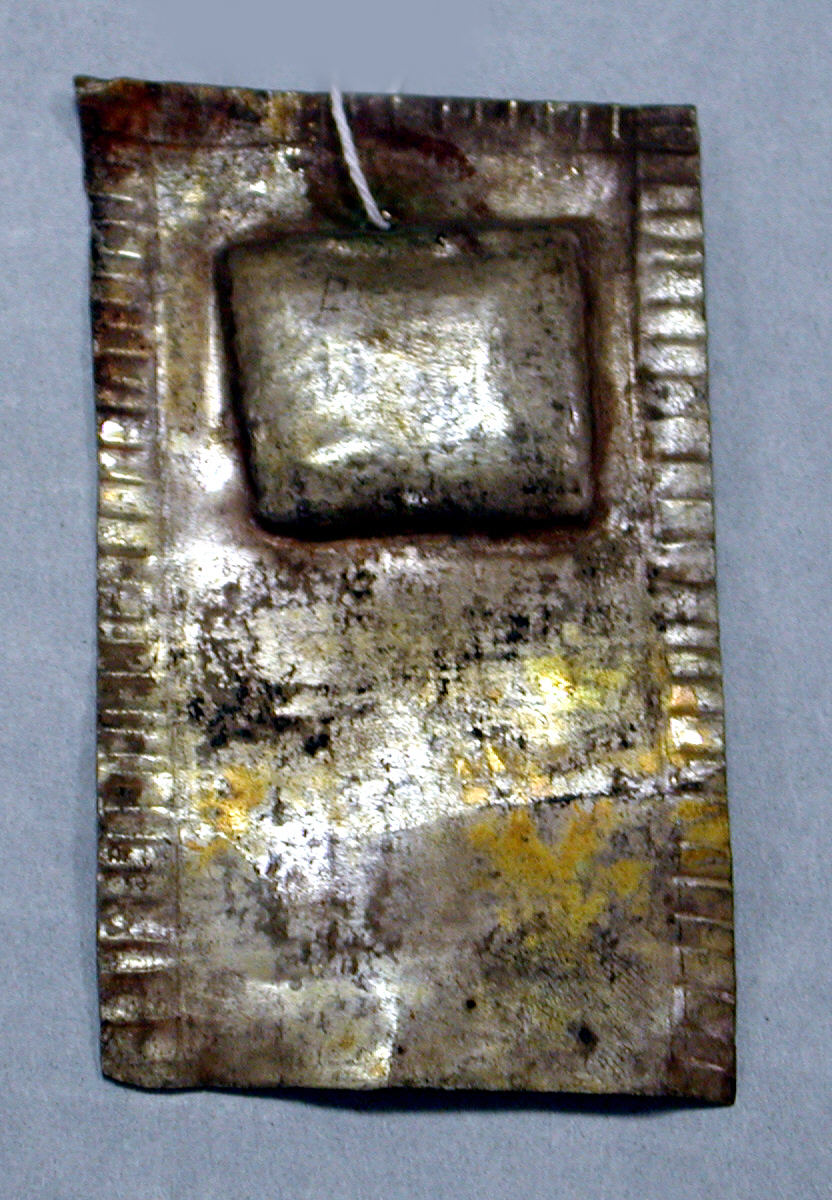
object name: ornament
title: Hammered Silver Ornament Plaque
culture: chancay or chimú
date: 1001-1500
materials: gilt, silver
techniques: hammering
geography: peru